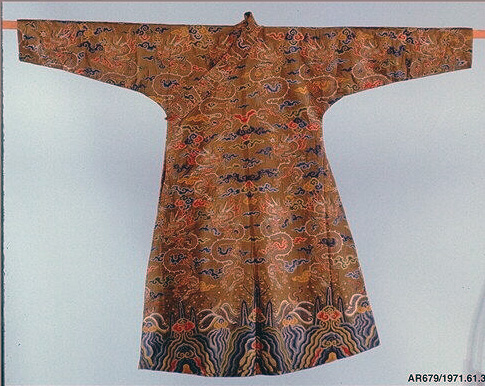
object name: robe, lay aristocrat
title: Robe for Lay Aristocrat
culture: tibetan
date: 1901-1933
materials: silk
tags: dragons